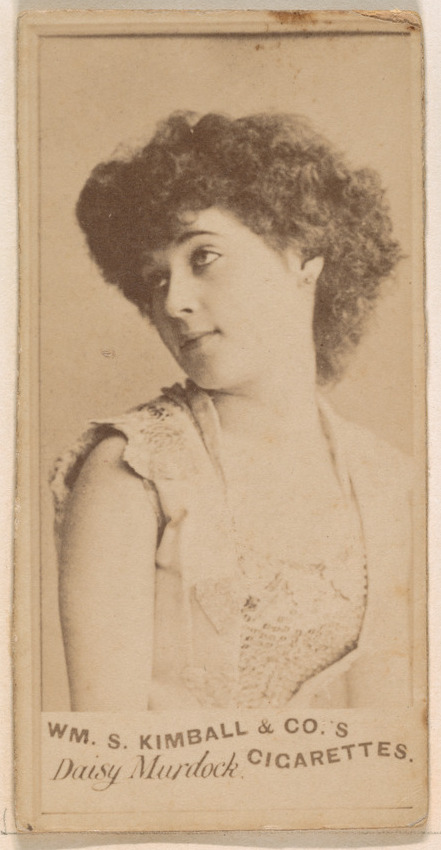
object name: photograph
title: Daisy Murdock, from the Actresses series (N203) issued by Wm. S. Kimball & Co.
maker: william s. kimball & company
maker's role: publisher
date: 1889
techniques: color lithograph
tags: portraits,women,actresses